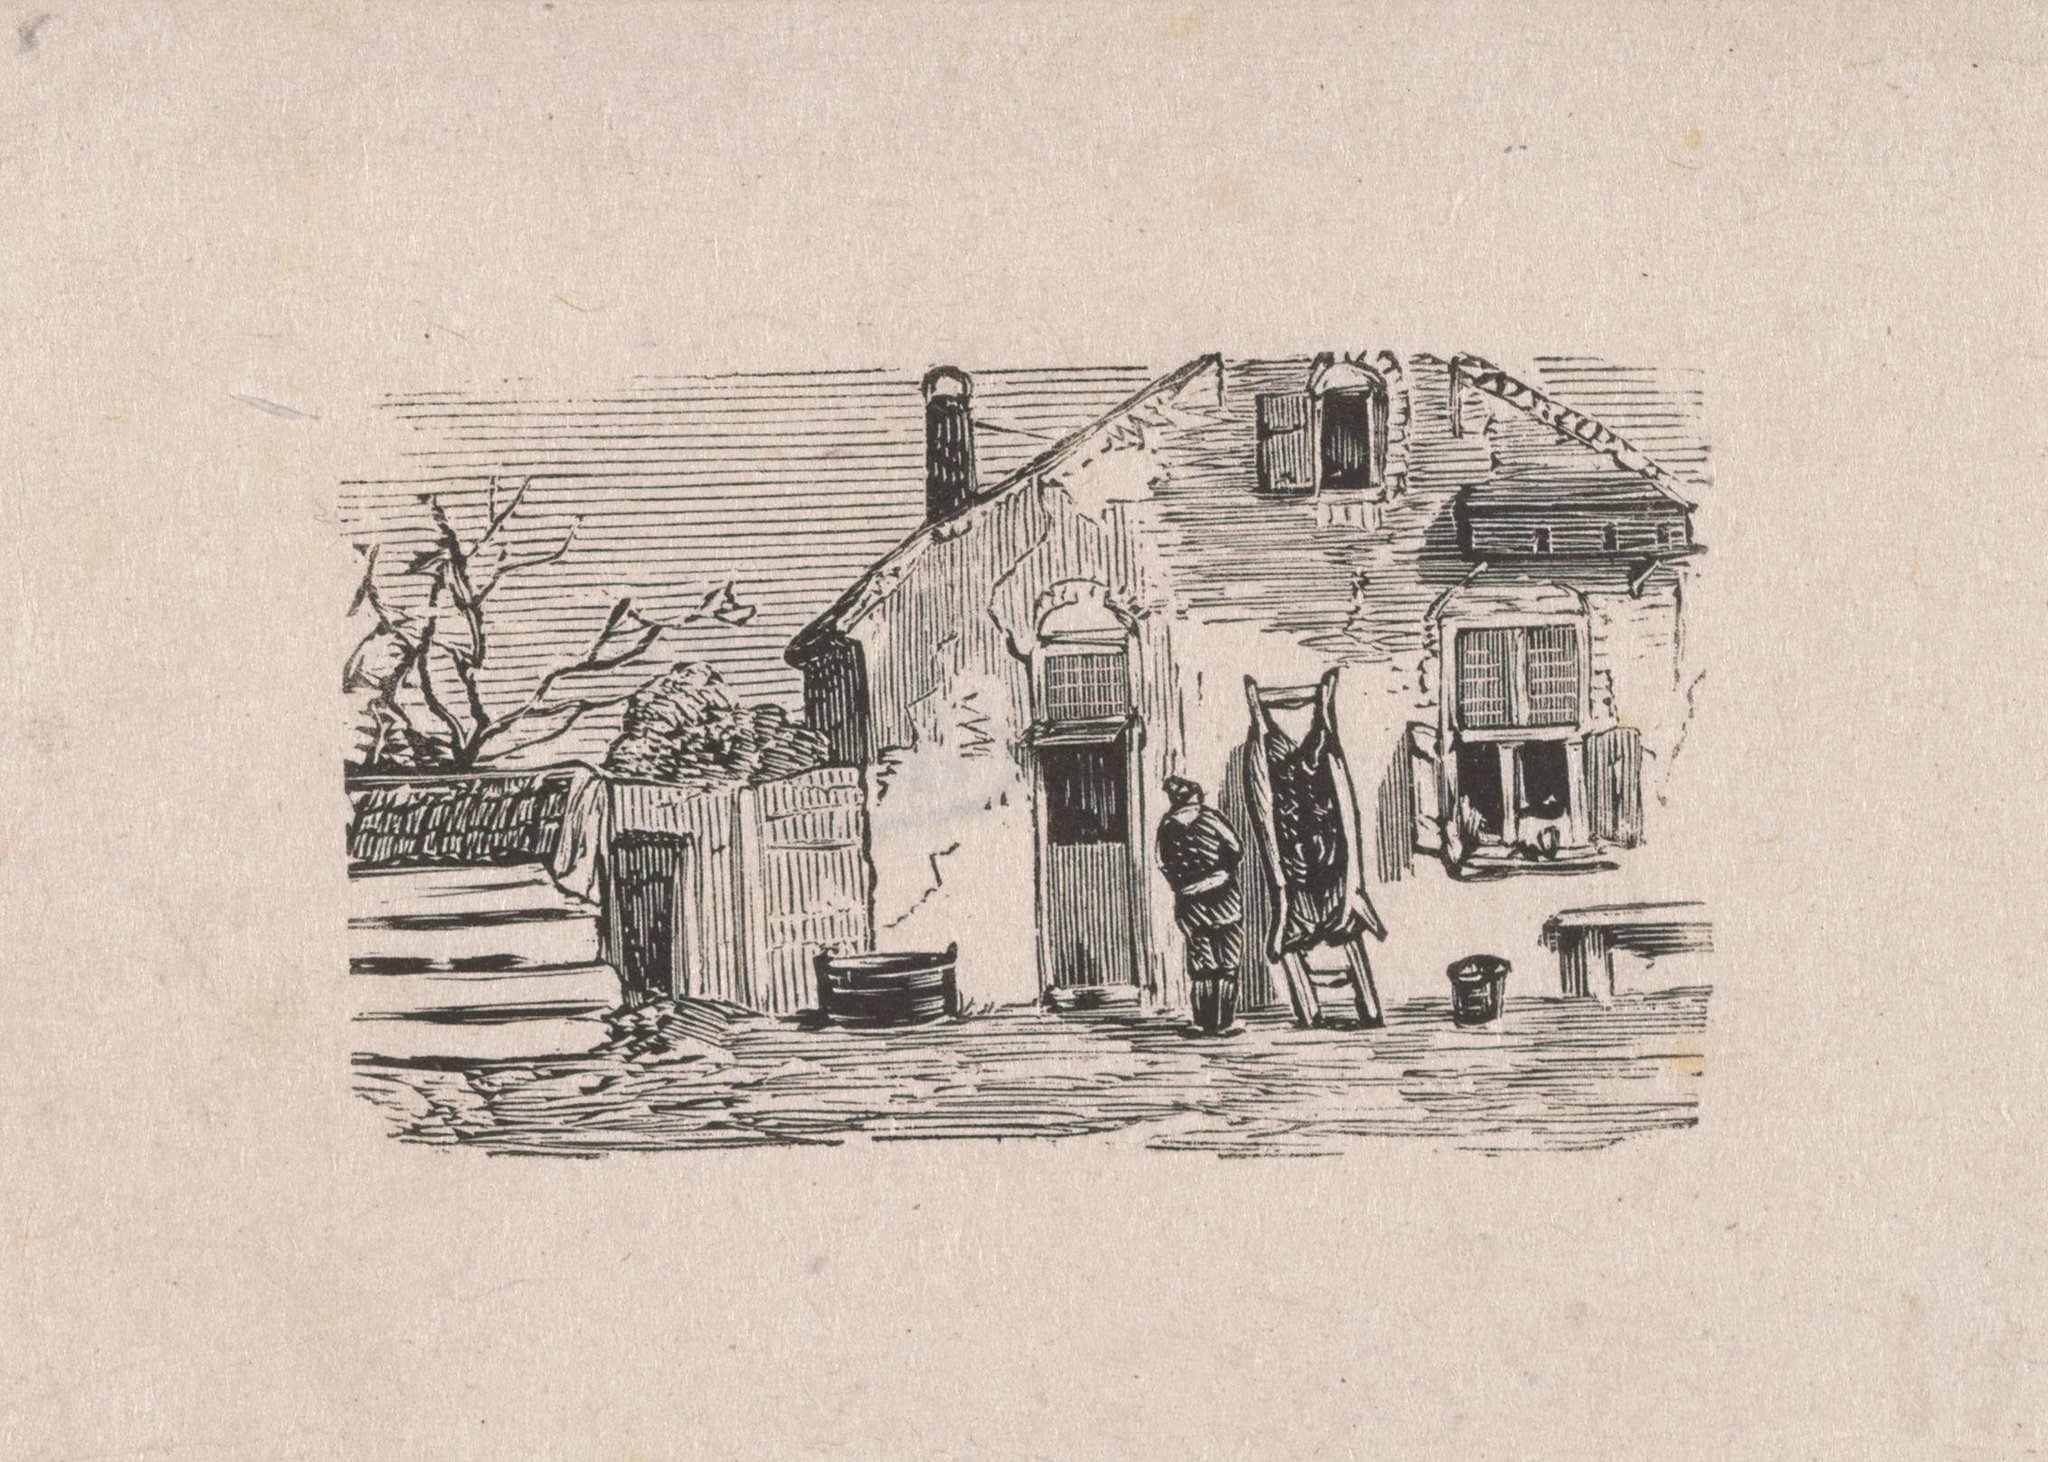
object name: print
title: Maanden van het jaar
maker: isaac weissenbruch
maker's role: print maker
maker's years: 1826-1912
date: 1836-1912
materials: paper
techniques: engraving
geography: netherlands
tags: the twelve months represented by scenes showing human activities, usually in a landscape; so-called 'labours of the months', adult man (+ standing)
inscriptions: collector's mark: Lugt 2228